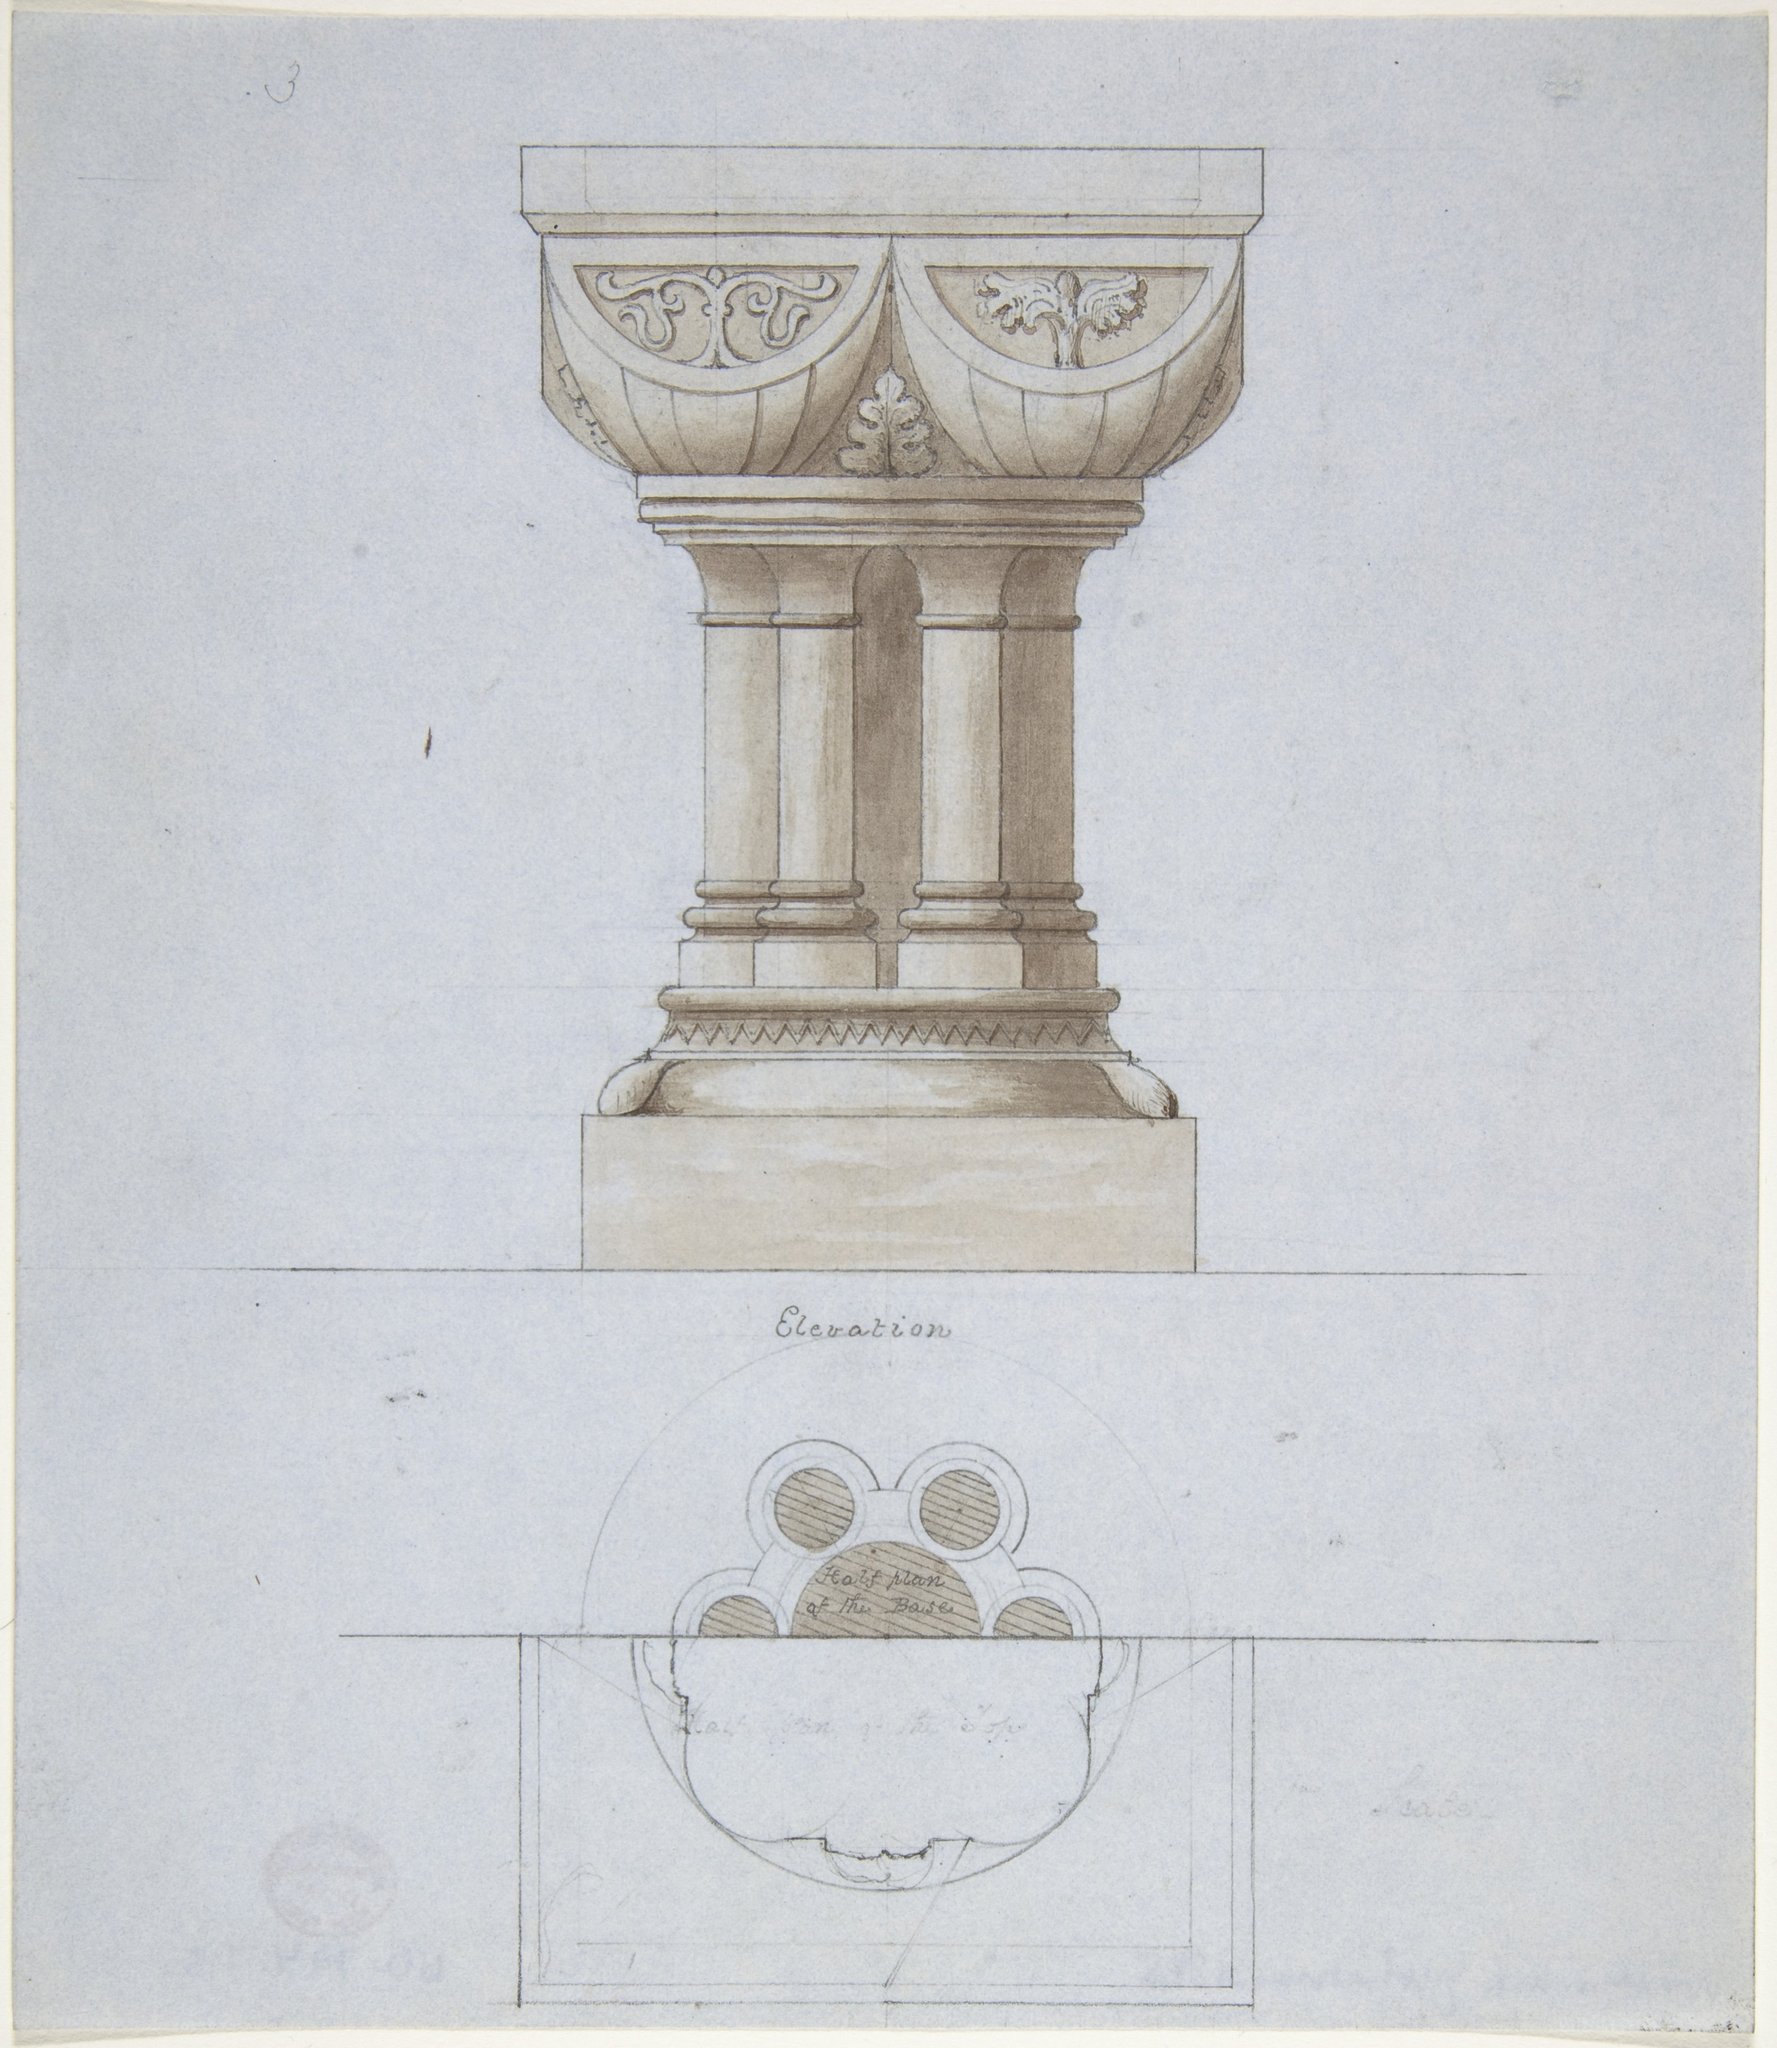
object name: drawing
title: Romanesque Style Font and Plan (recto); One Font (verso)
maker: anonymous, british, 19th century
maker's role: artist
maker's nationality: british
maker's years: 1800-1900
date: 1834-1866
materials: graphite, ink, paper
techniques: brush, pen, wash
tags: baptismal fonts